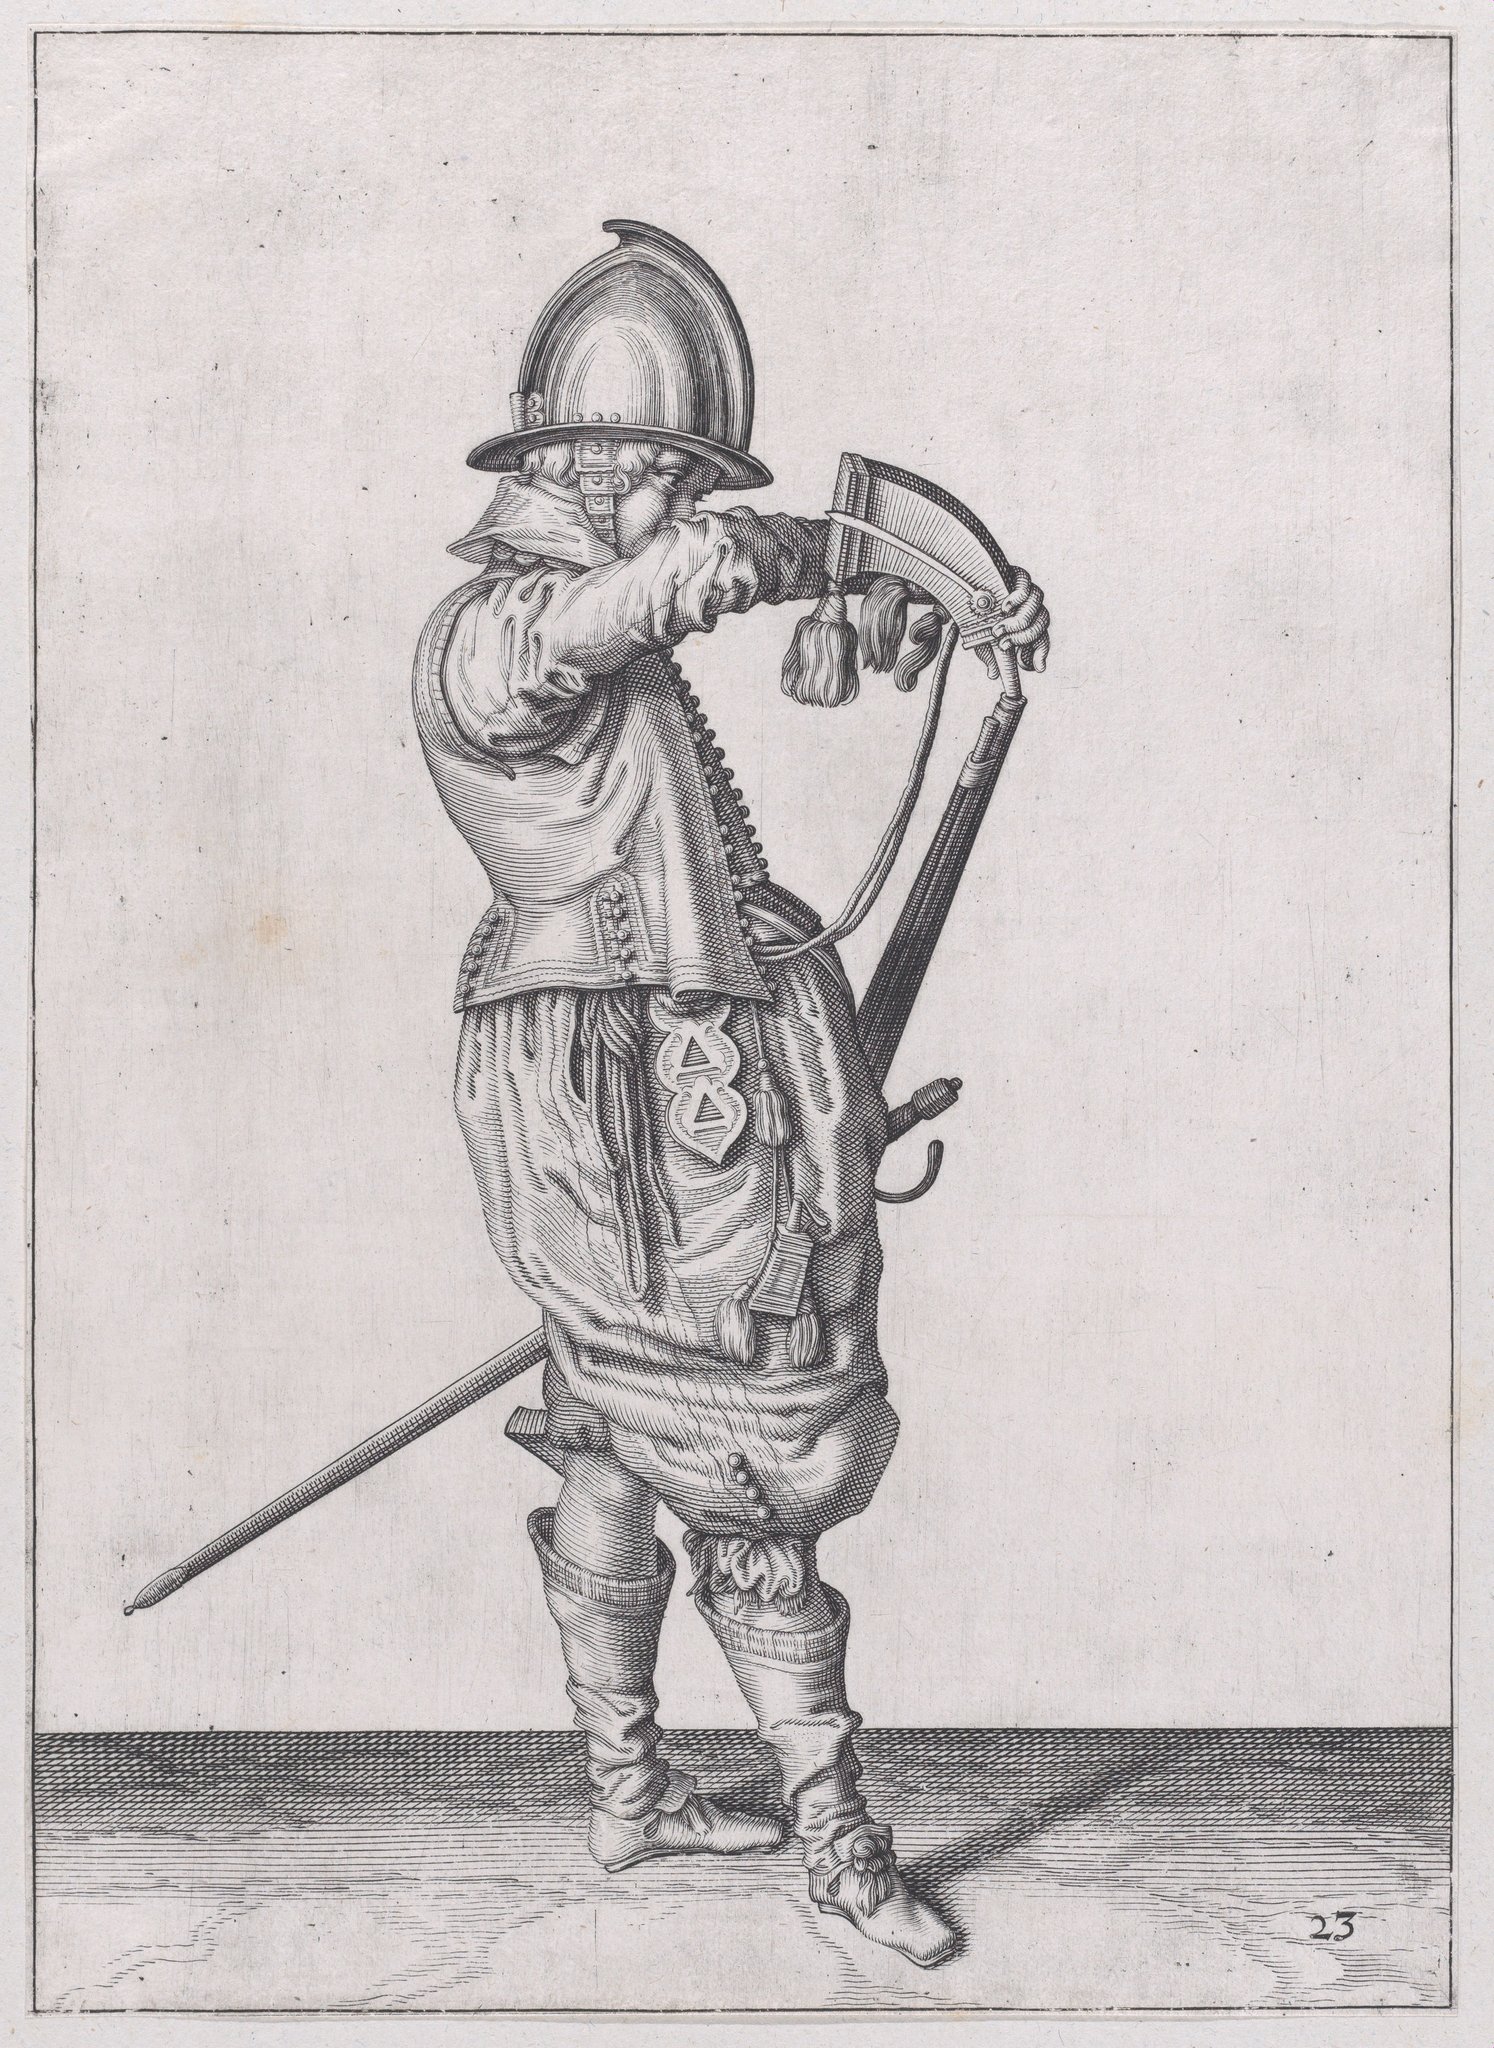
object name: print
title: A soldier charging his caliver which is held stock down, from the Marksmen series, plate 23, in Waffenhandlung von den Rören Musquetten undt Spiessen / Wapenhandelinghe van Roers Musquetten ende Spiessen (The Exercise of Arms)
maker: jacques de gheyn (ii)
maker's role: artist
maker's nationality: netherlandish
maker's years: 1565-1629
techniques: engraving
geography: the hague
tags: soldiers,firearms,men